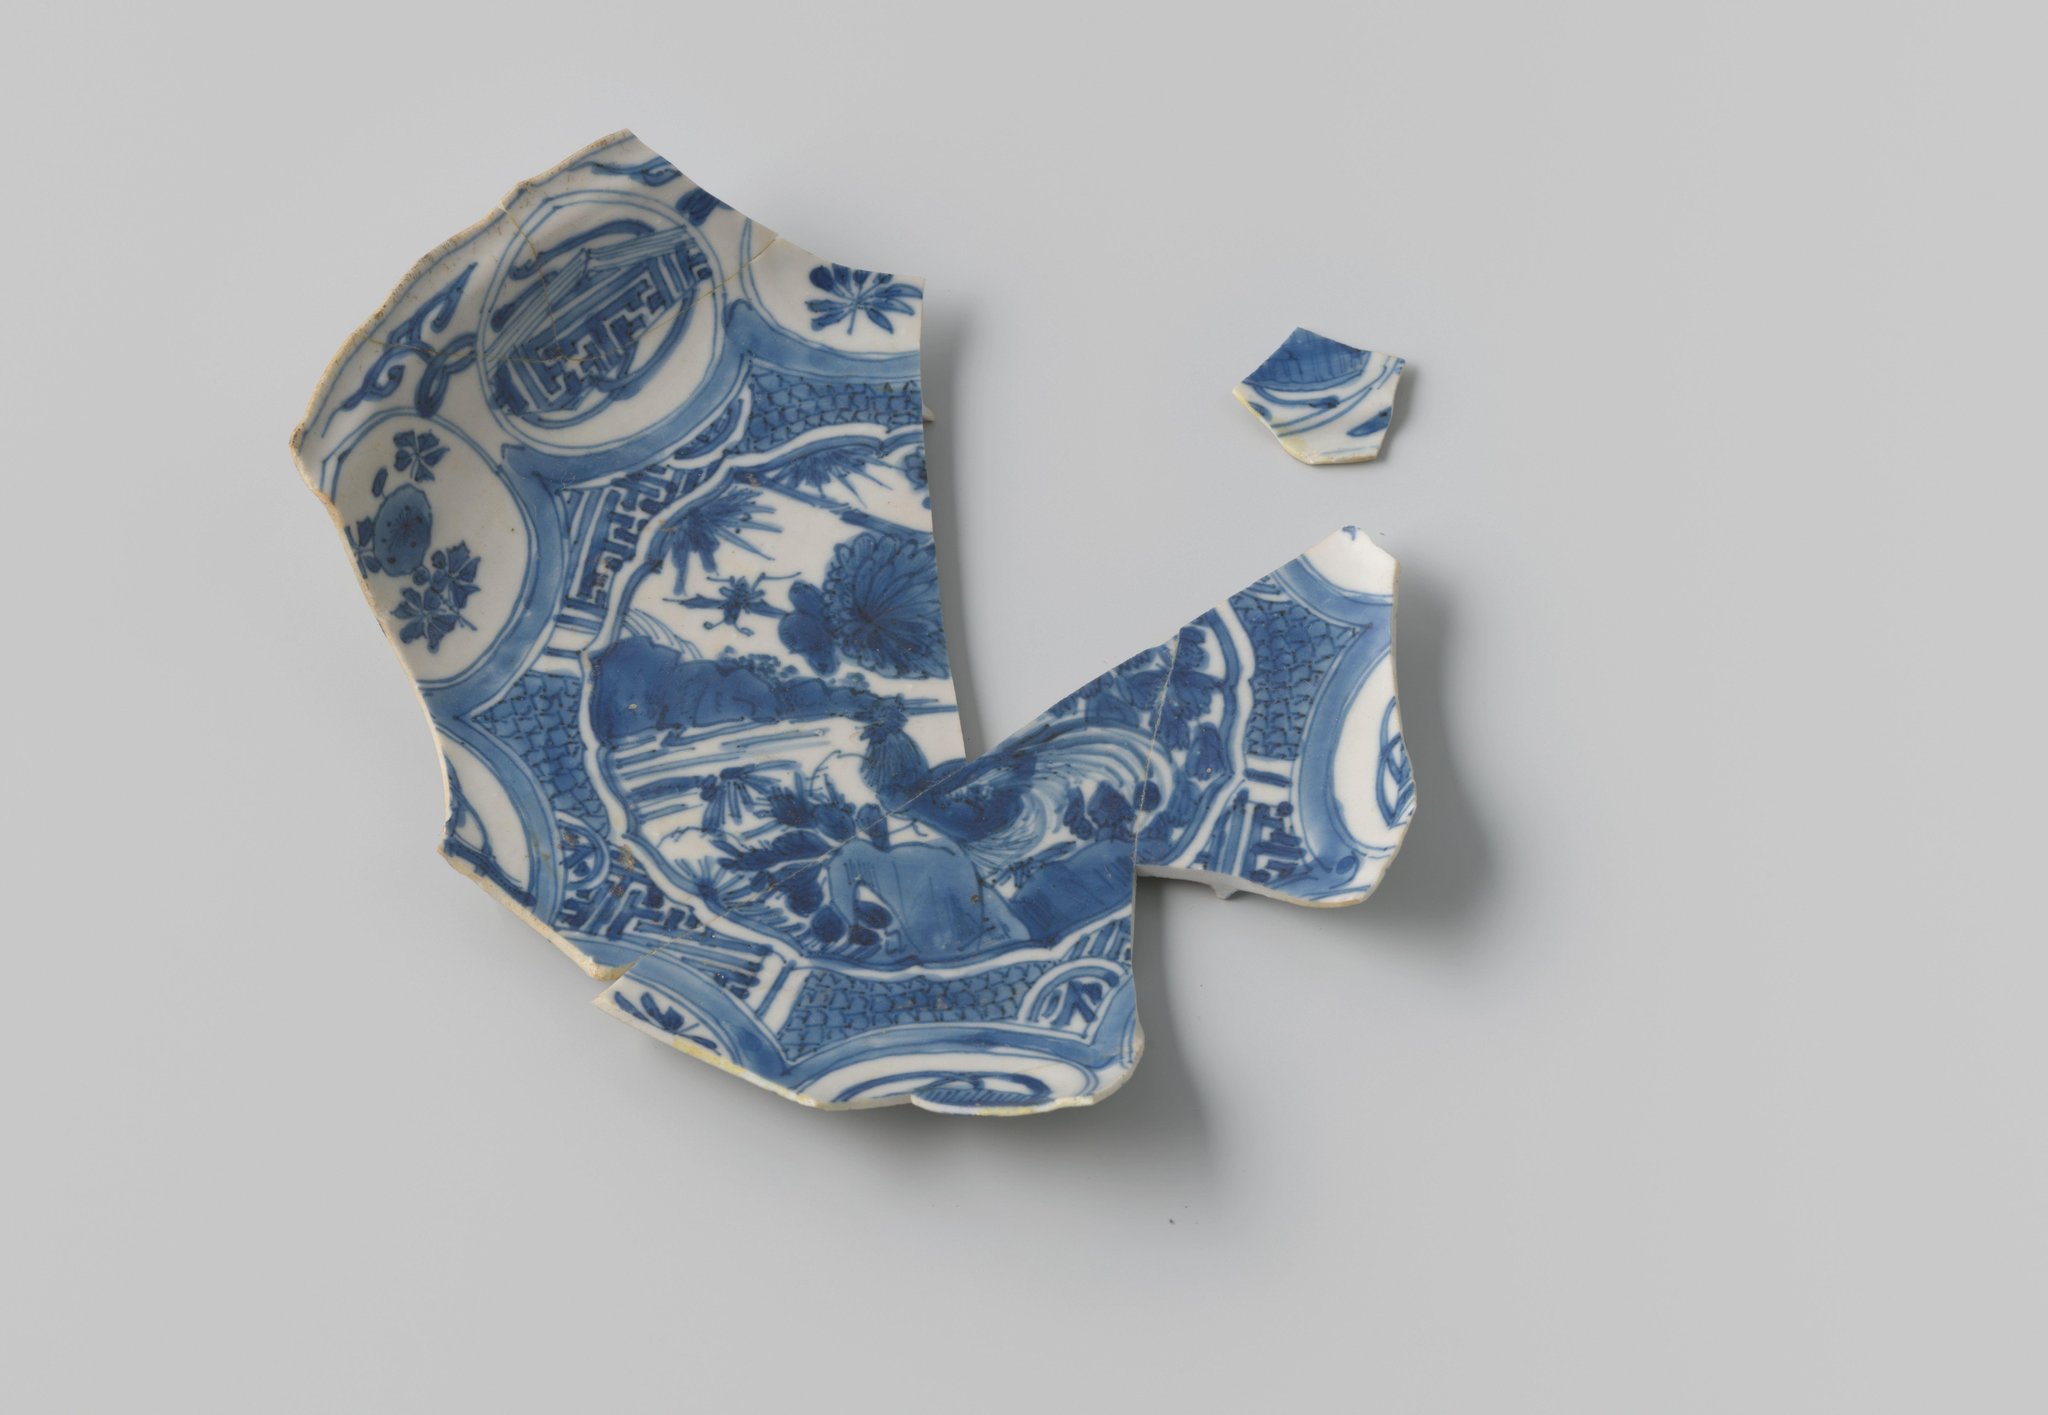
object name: plate dish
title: Scherven van een bord uit V.O.C.-schip de 'Witte leeuw'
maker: Anonymous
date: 1613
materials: bone china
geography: jingdezhen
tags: verenigde oostindische compagnie, sint-helena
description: A dish without a flattened rim. A scalloped medallion with rui heads laternating with radial panels within a star shaped medallion, filled with various diaper patterns. A central decoration of a rooster on rock under a chrysanthemum and bamboo with a flying insect. Medallions decorated with alternately a peach or fruit and a symbol.